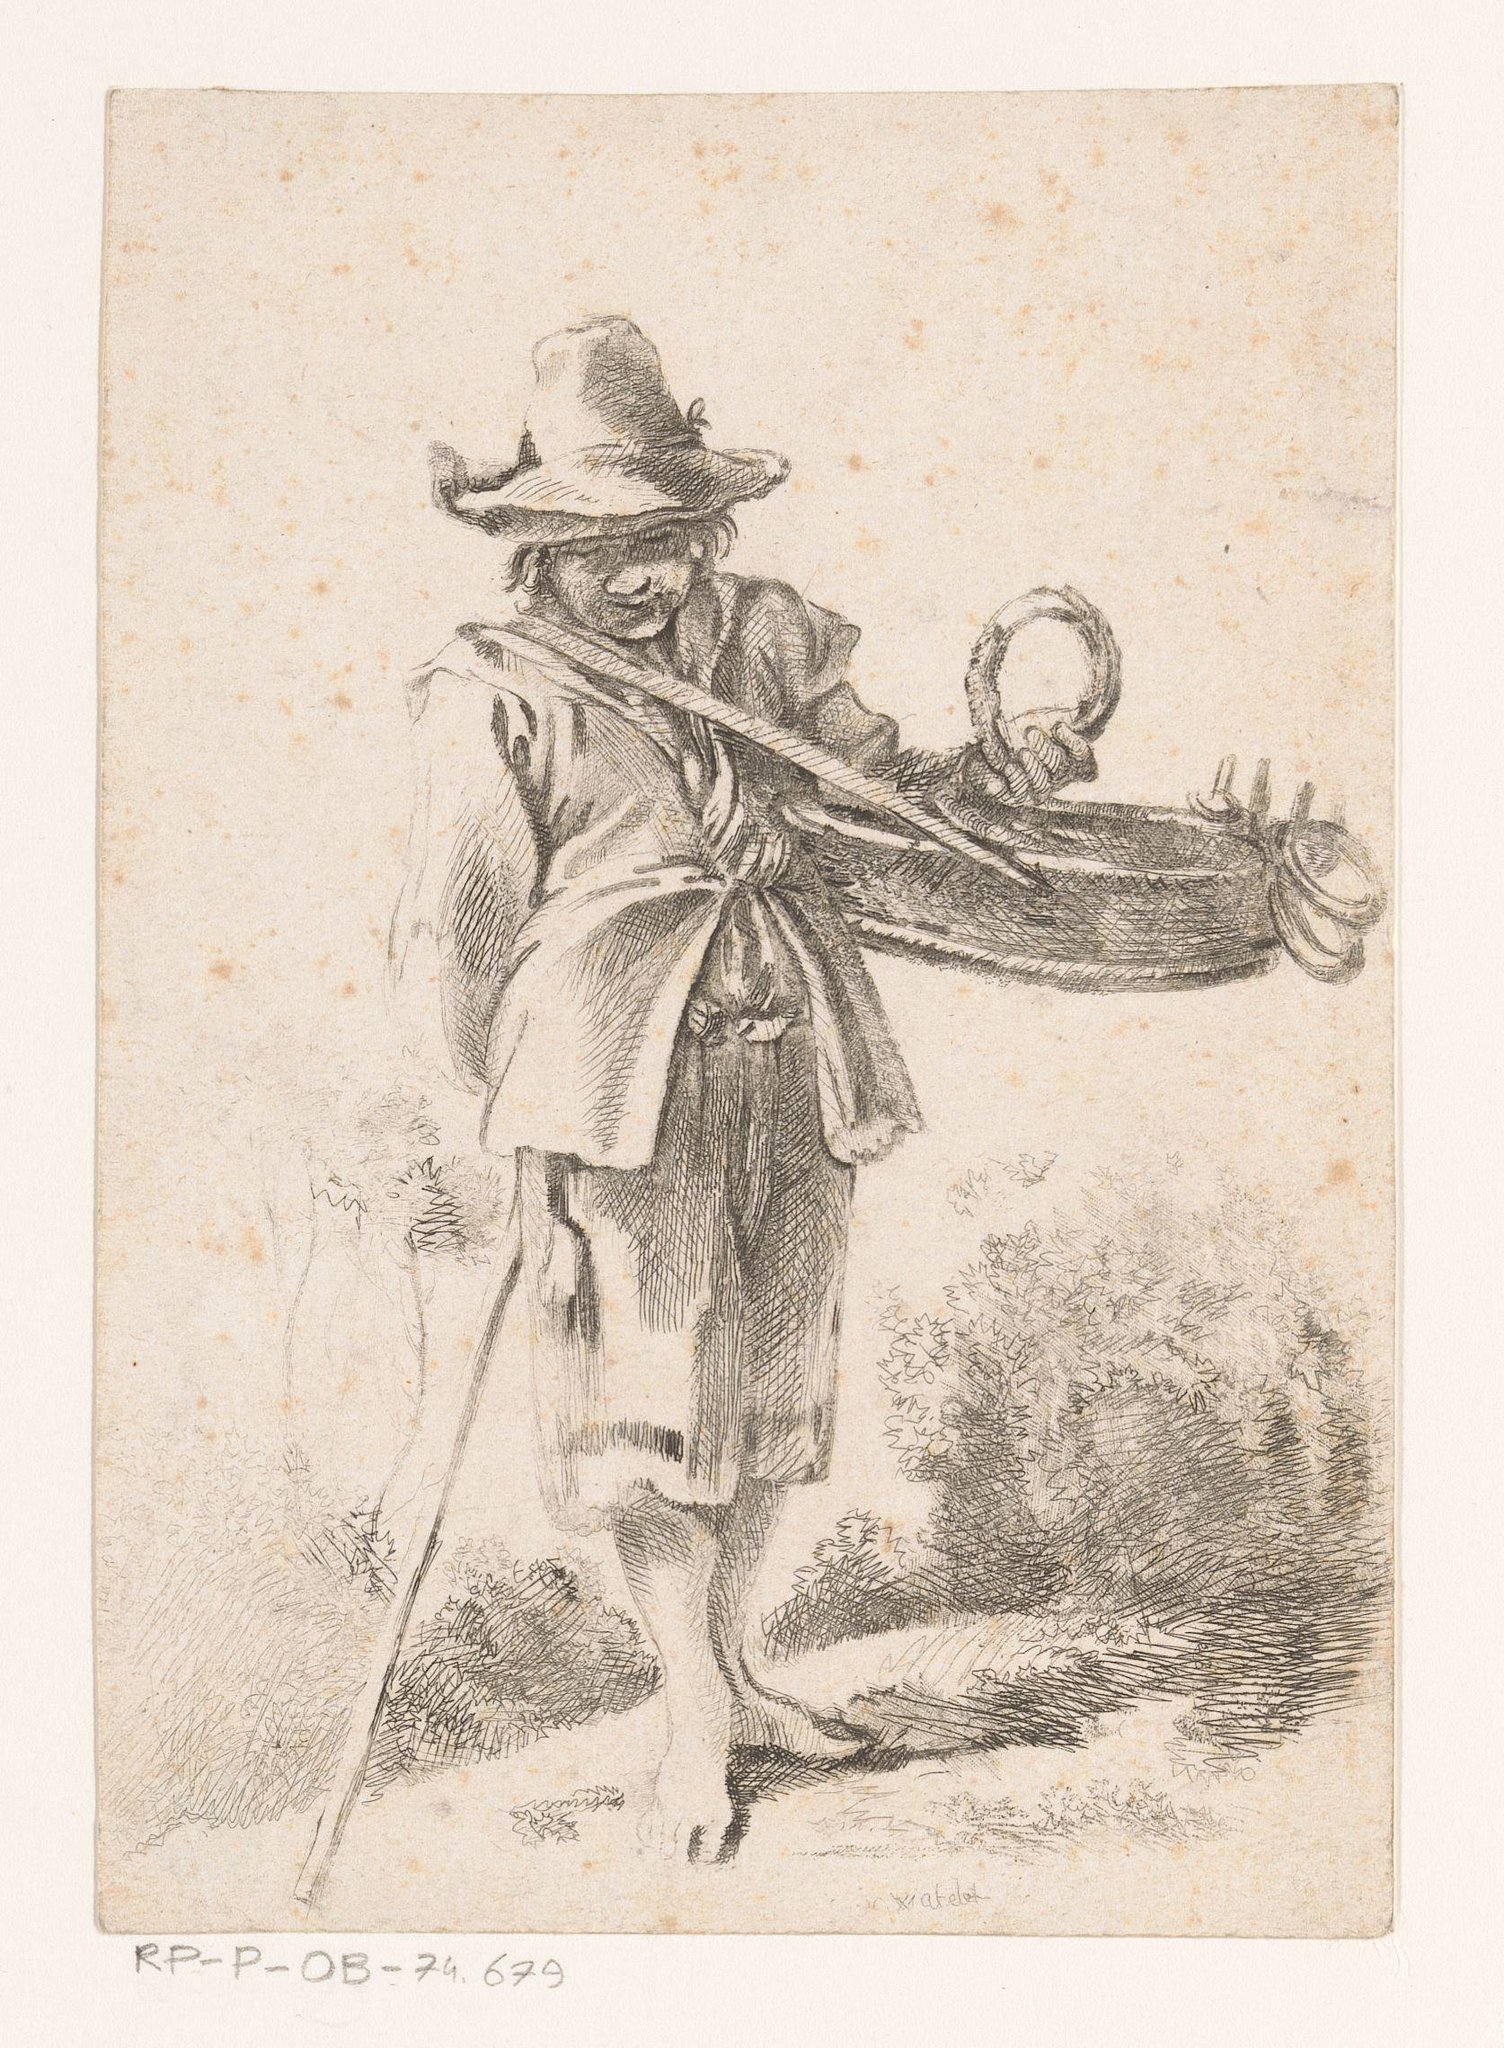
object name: print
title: Jonge verkoper van broodwaren in een landschap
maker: claude henri watelet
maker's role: print maker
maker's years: 1718-1786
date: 1728-1786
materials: paper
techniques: etching, intaglio, roulette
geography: france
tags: boy (child between toddler and youth), container made of plant material other than wood: basket, merchant, salesman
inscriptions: collector's mark: Lugt 2228, collector's mark